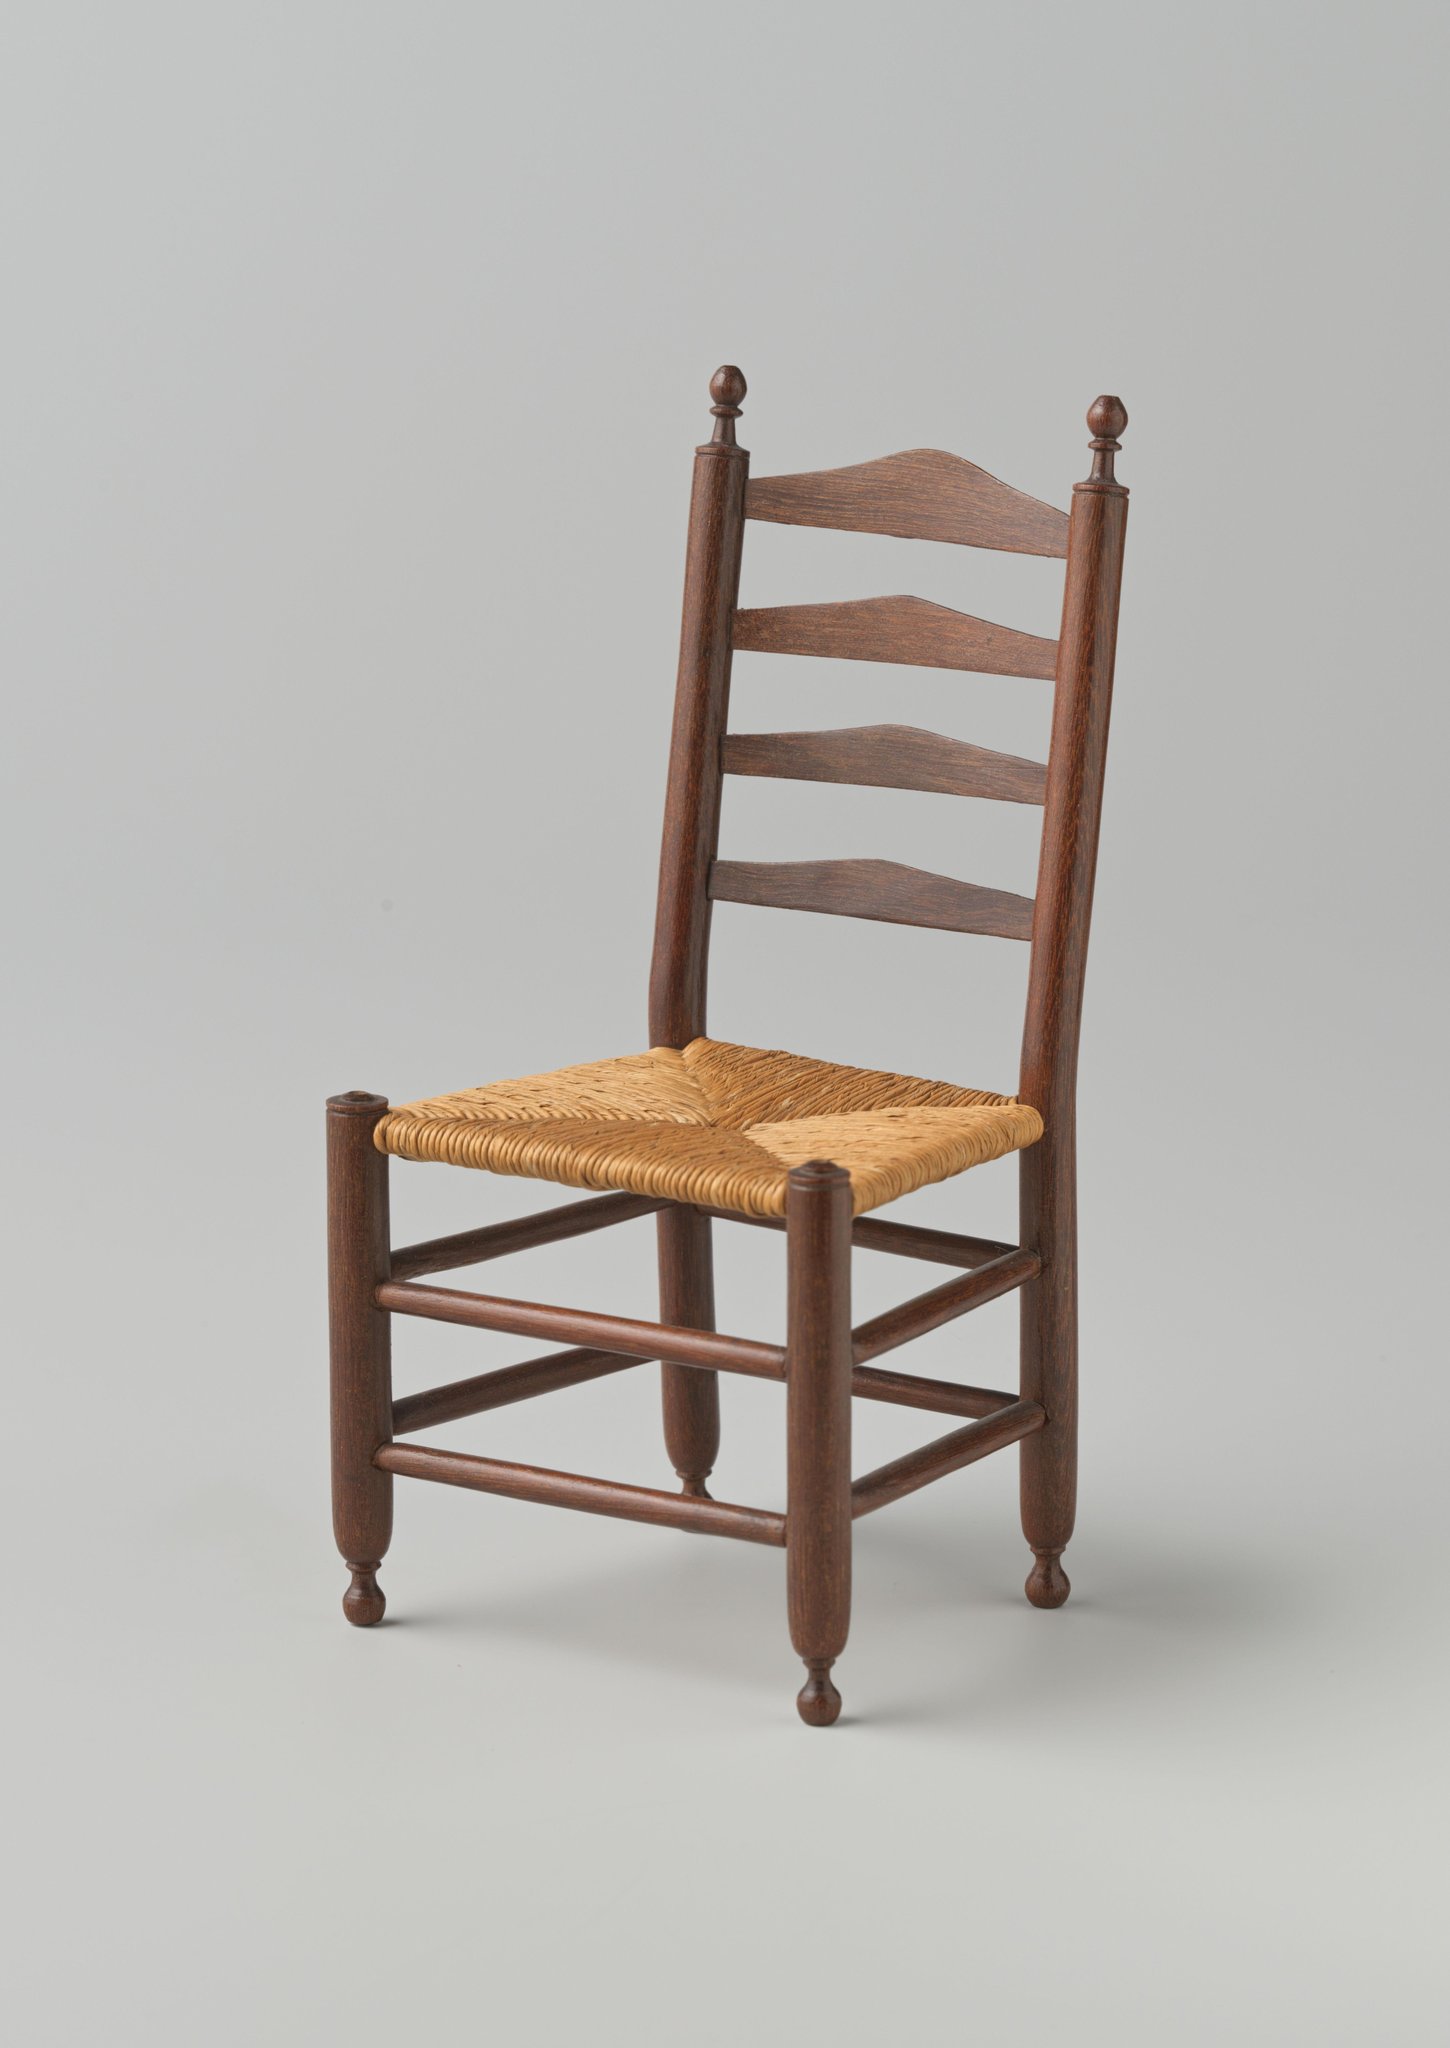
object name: chair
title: Knopstoel van hardhout met gladde, gedraaide stijlen en dwaarsregels; voorpoten en achterstijlen eindigend in fijn gedraaide knoppen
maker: Anonymous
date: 1690-1710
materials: wood, fiber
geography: amsterdam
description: Deze stoel heeft een hogere zitting dan de oevrige drie van een viertal waarvan het deel uitmaakt. Bij elke stoel hoort een kussen.